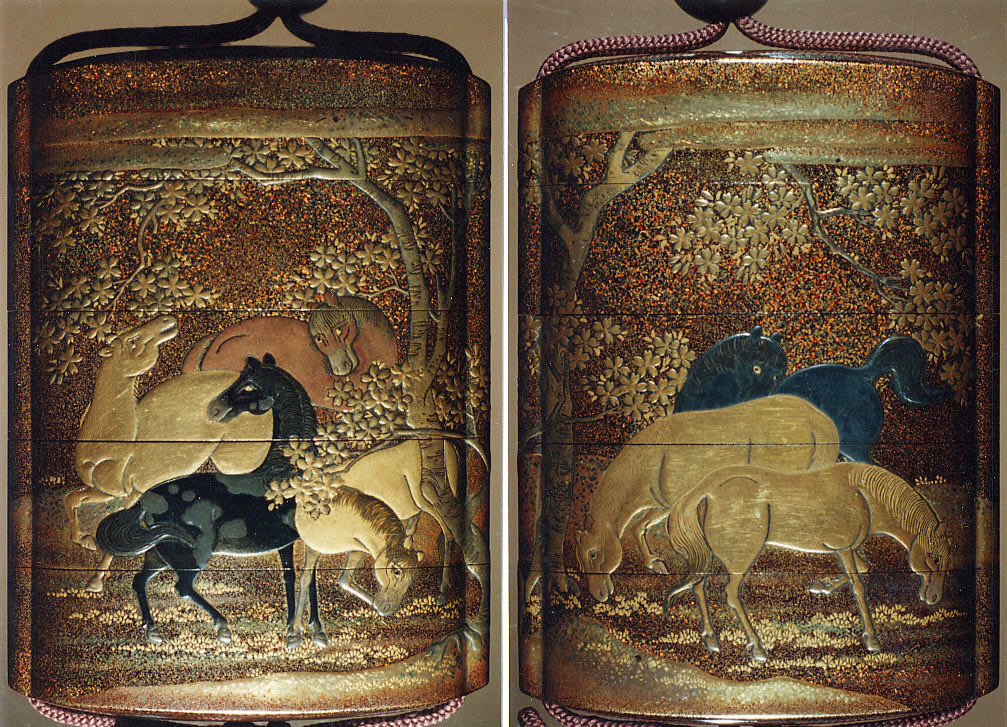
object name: inrō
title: Case (Inrō) with Design of Horses among Cherry Blossom Trees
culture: japanese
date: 1701-1900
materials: gold, lacquer, silver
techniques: fundame, hiramakie, maki-e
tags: horses,trees